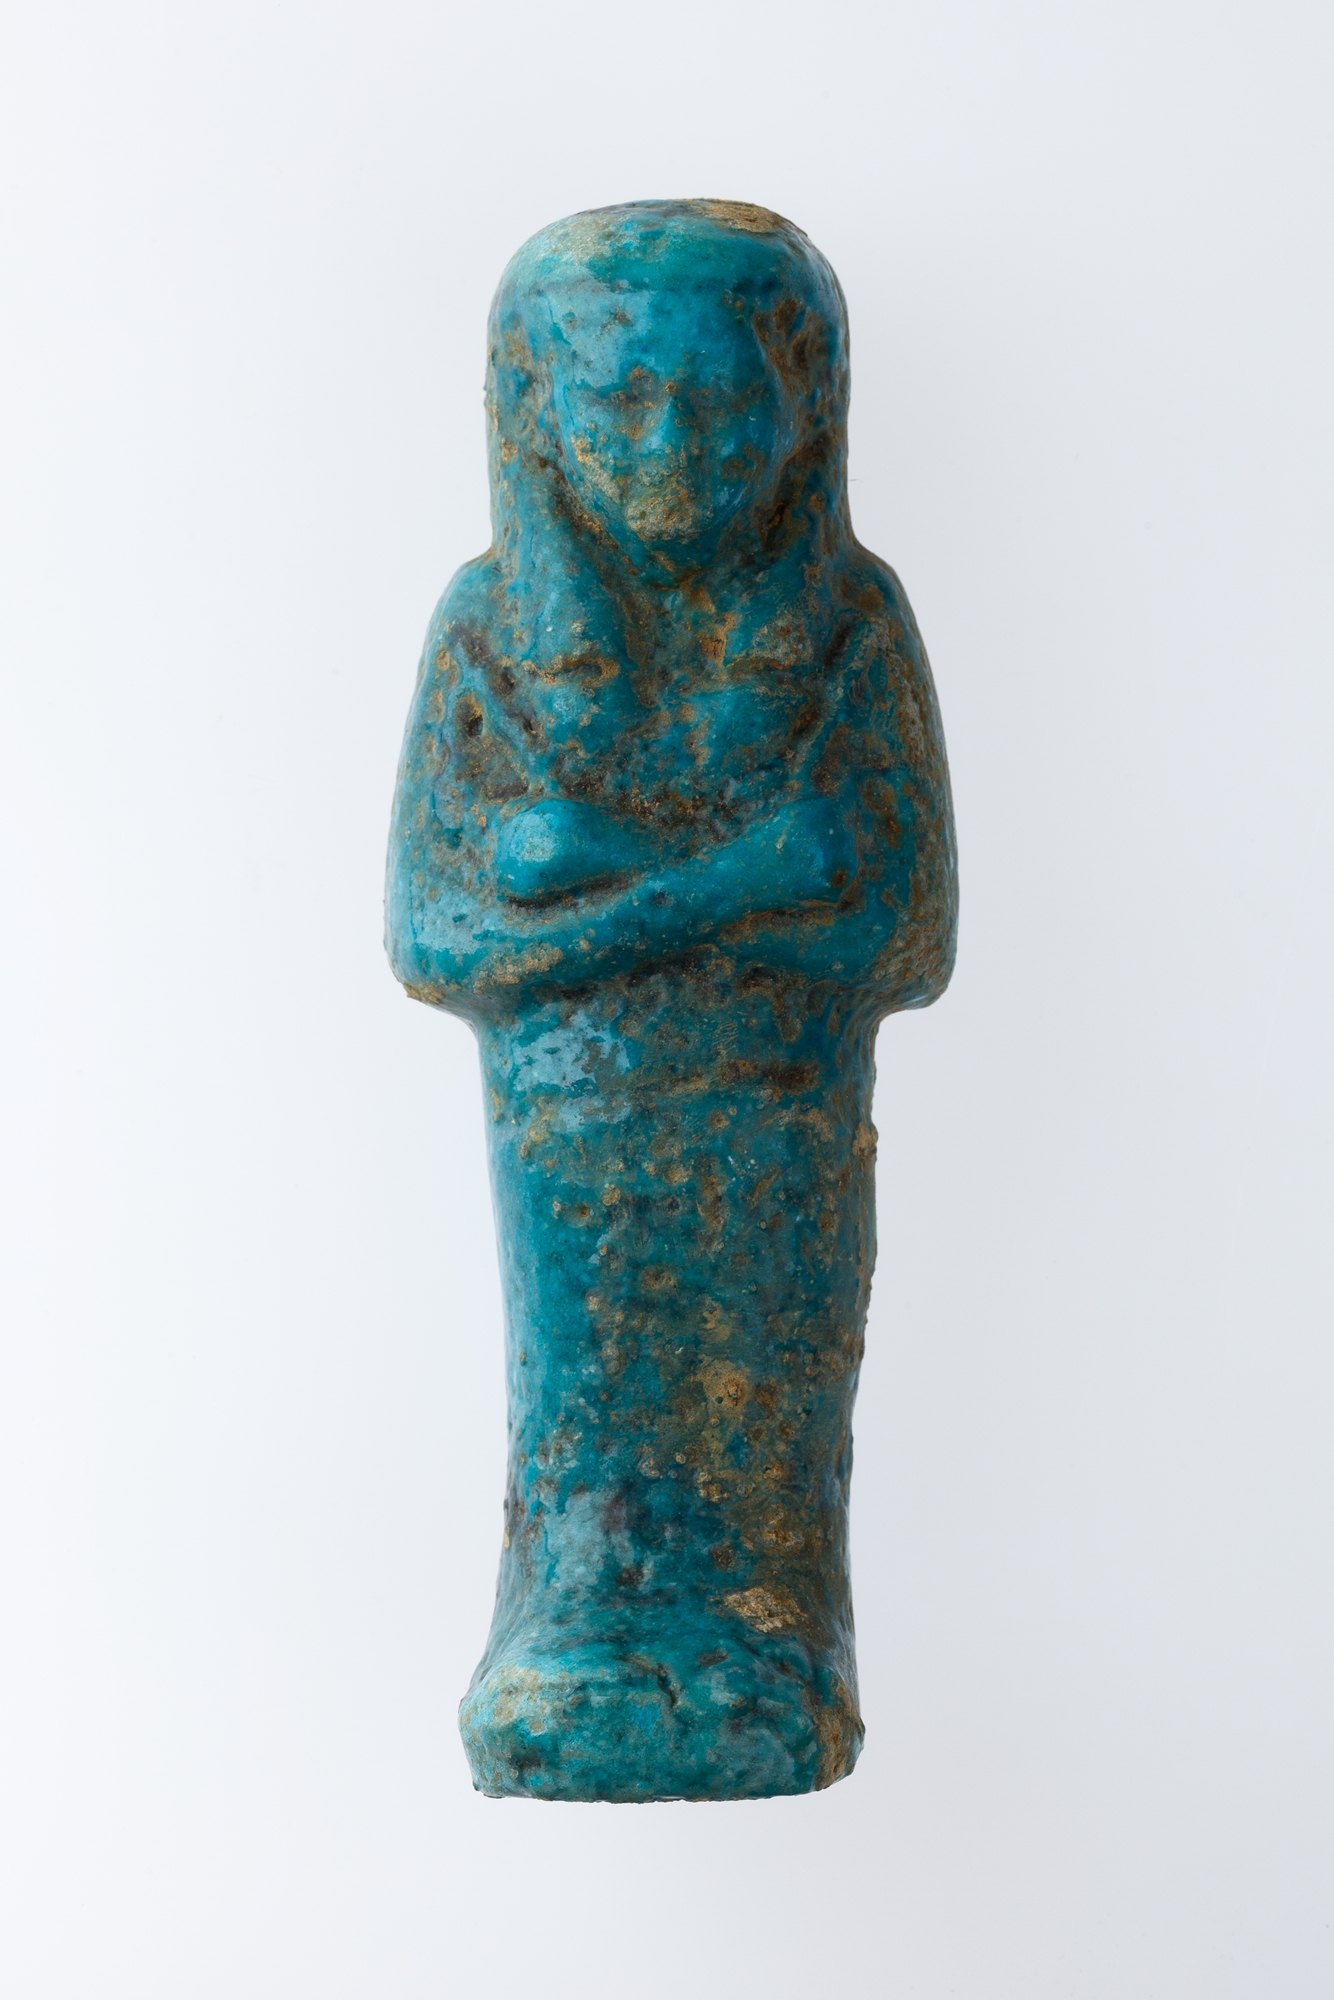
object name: shabti, henettawy c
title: Worker Shabti of Henettawy (C), Daughter of Isetemkheb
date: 990-970 BCE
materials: faience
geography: egypt